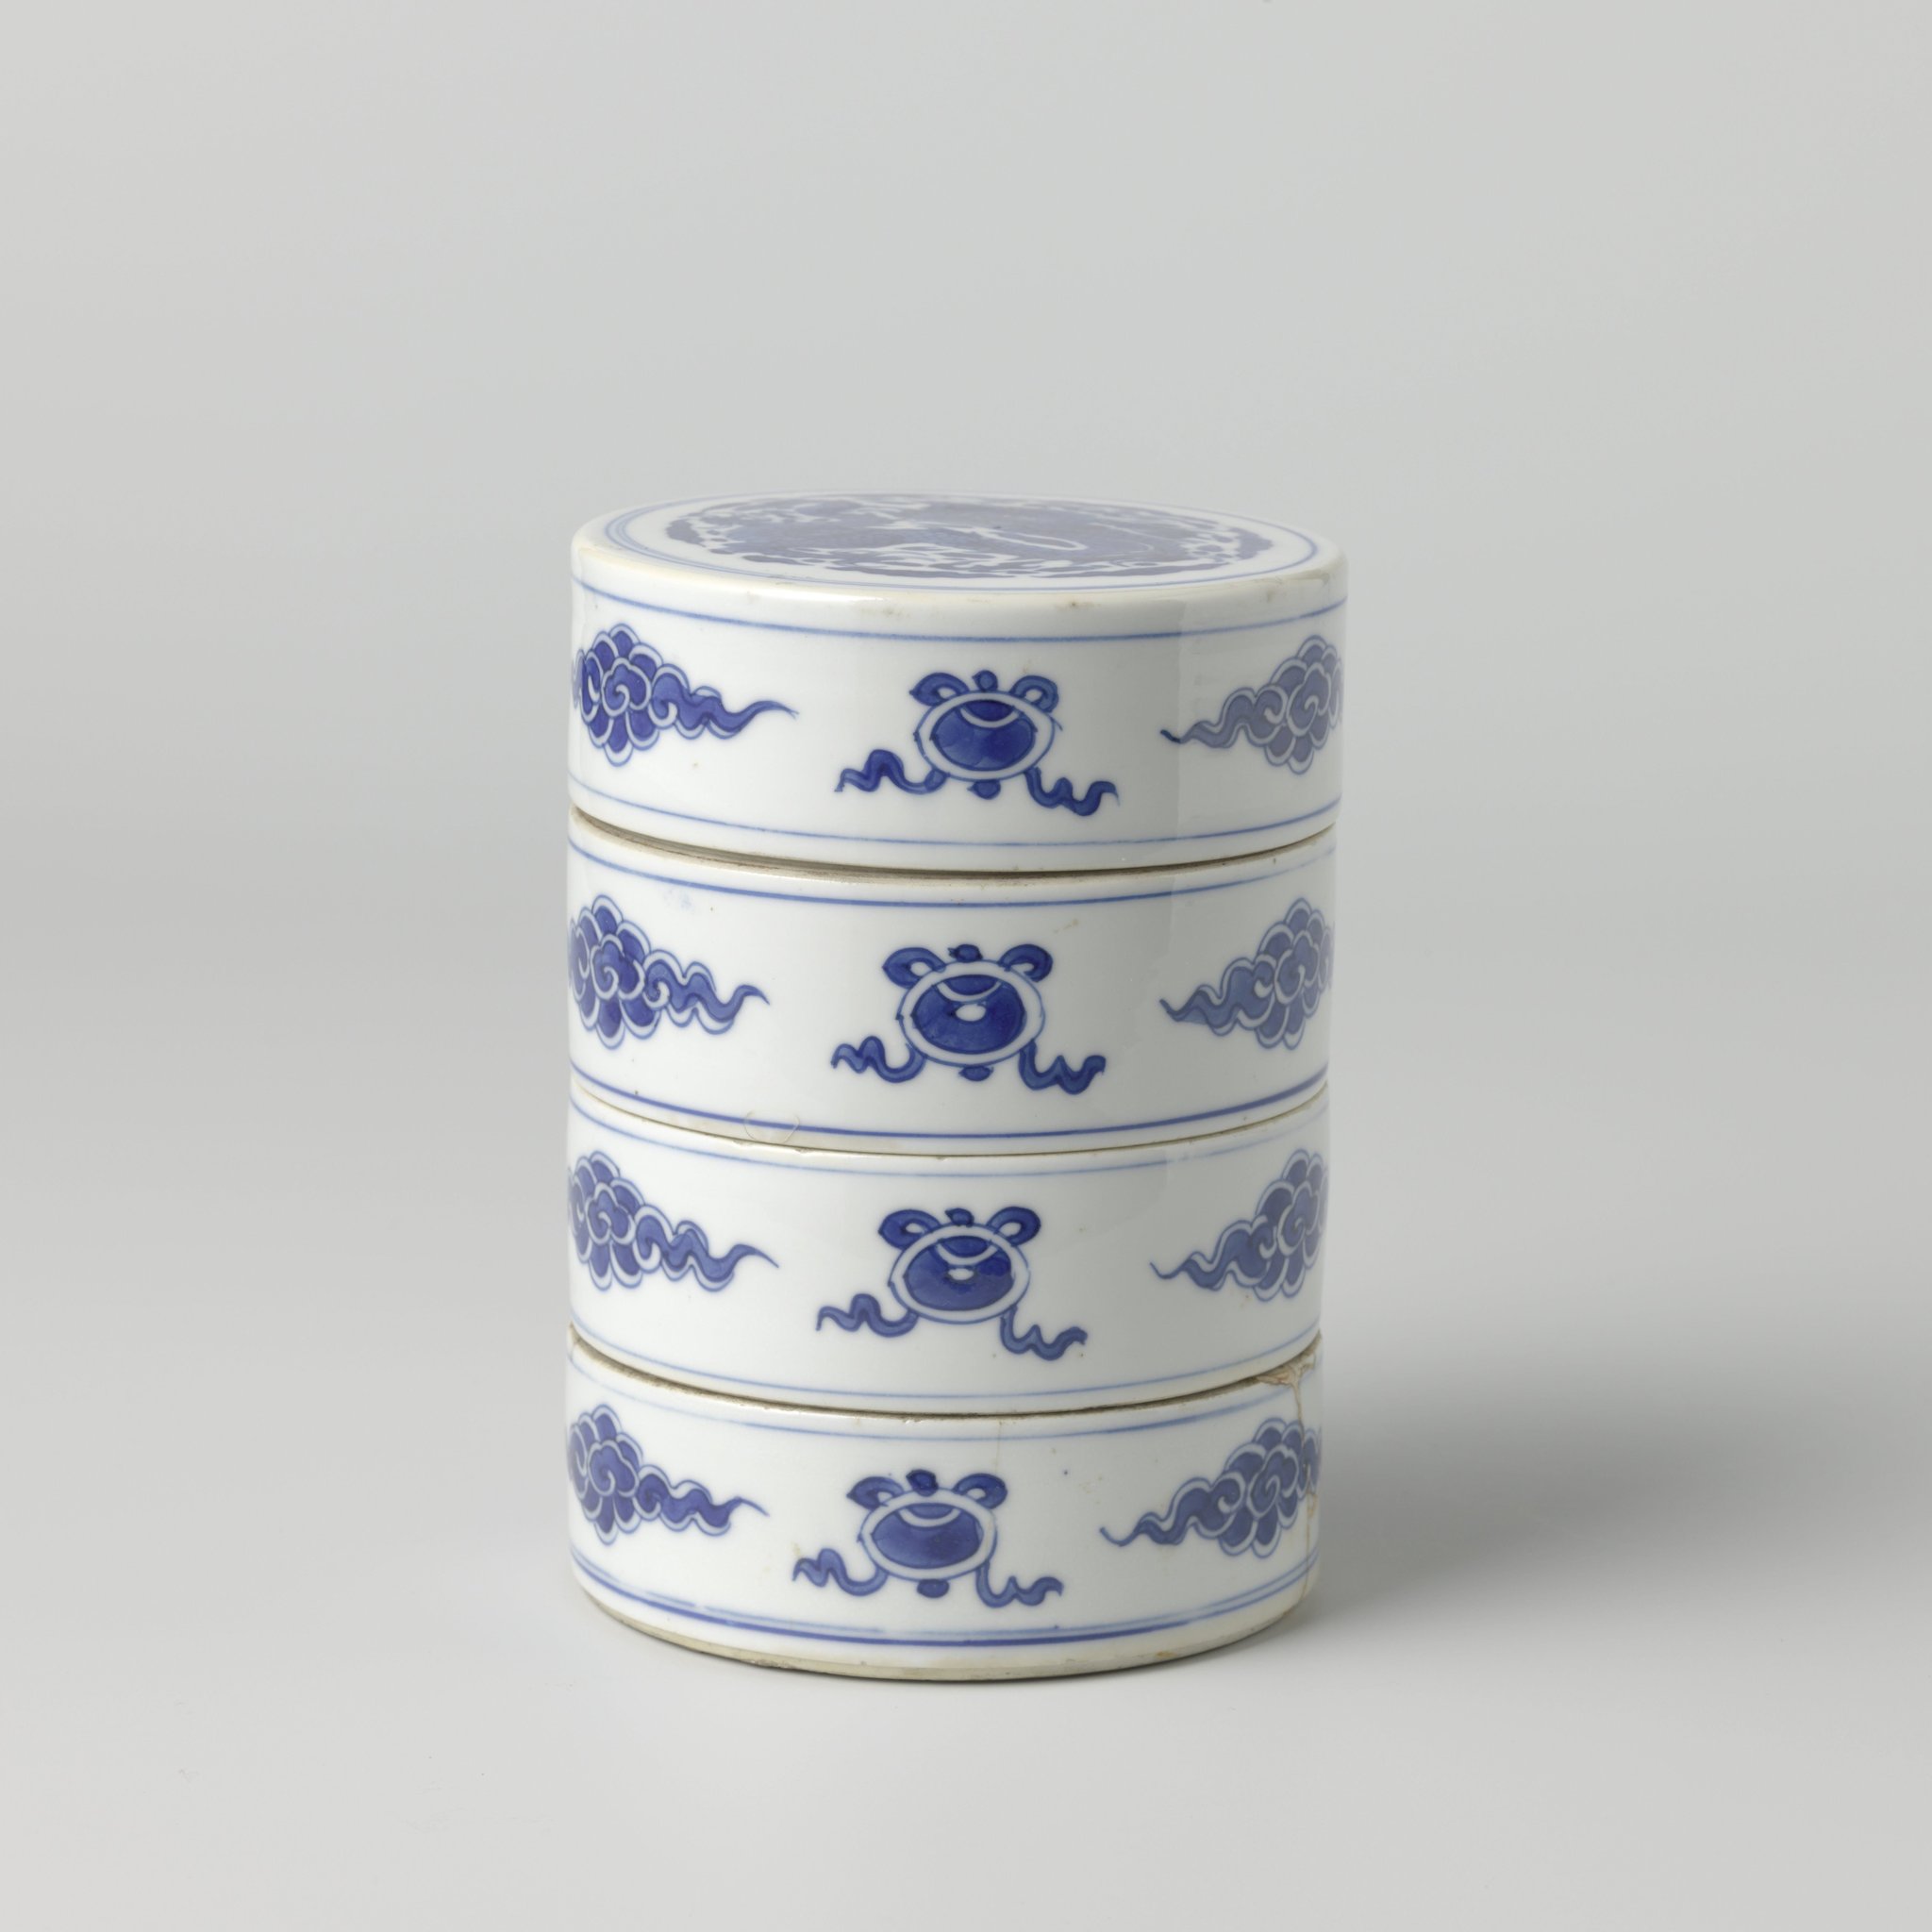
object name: stapeldoos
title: Tiered box composed of three layers with dragon en precious objects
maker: Anonymous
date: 1680-1720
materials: cobalt, glaze, paint, porcelain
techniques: firing, turning, vitrification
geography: china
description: Ronde stapeldoos van porselein bestaande uit drie lagen en een deksel, beschilderd in onderglazuur blauw. De wanden van de dozen en de deksel met wolkmotieven en kostbaarheden (parel, ruit, muzieksteen). Blauw-wit.